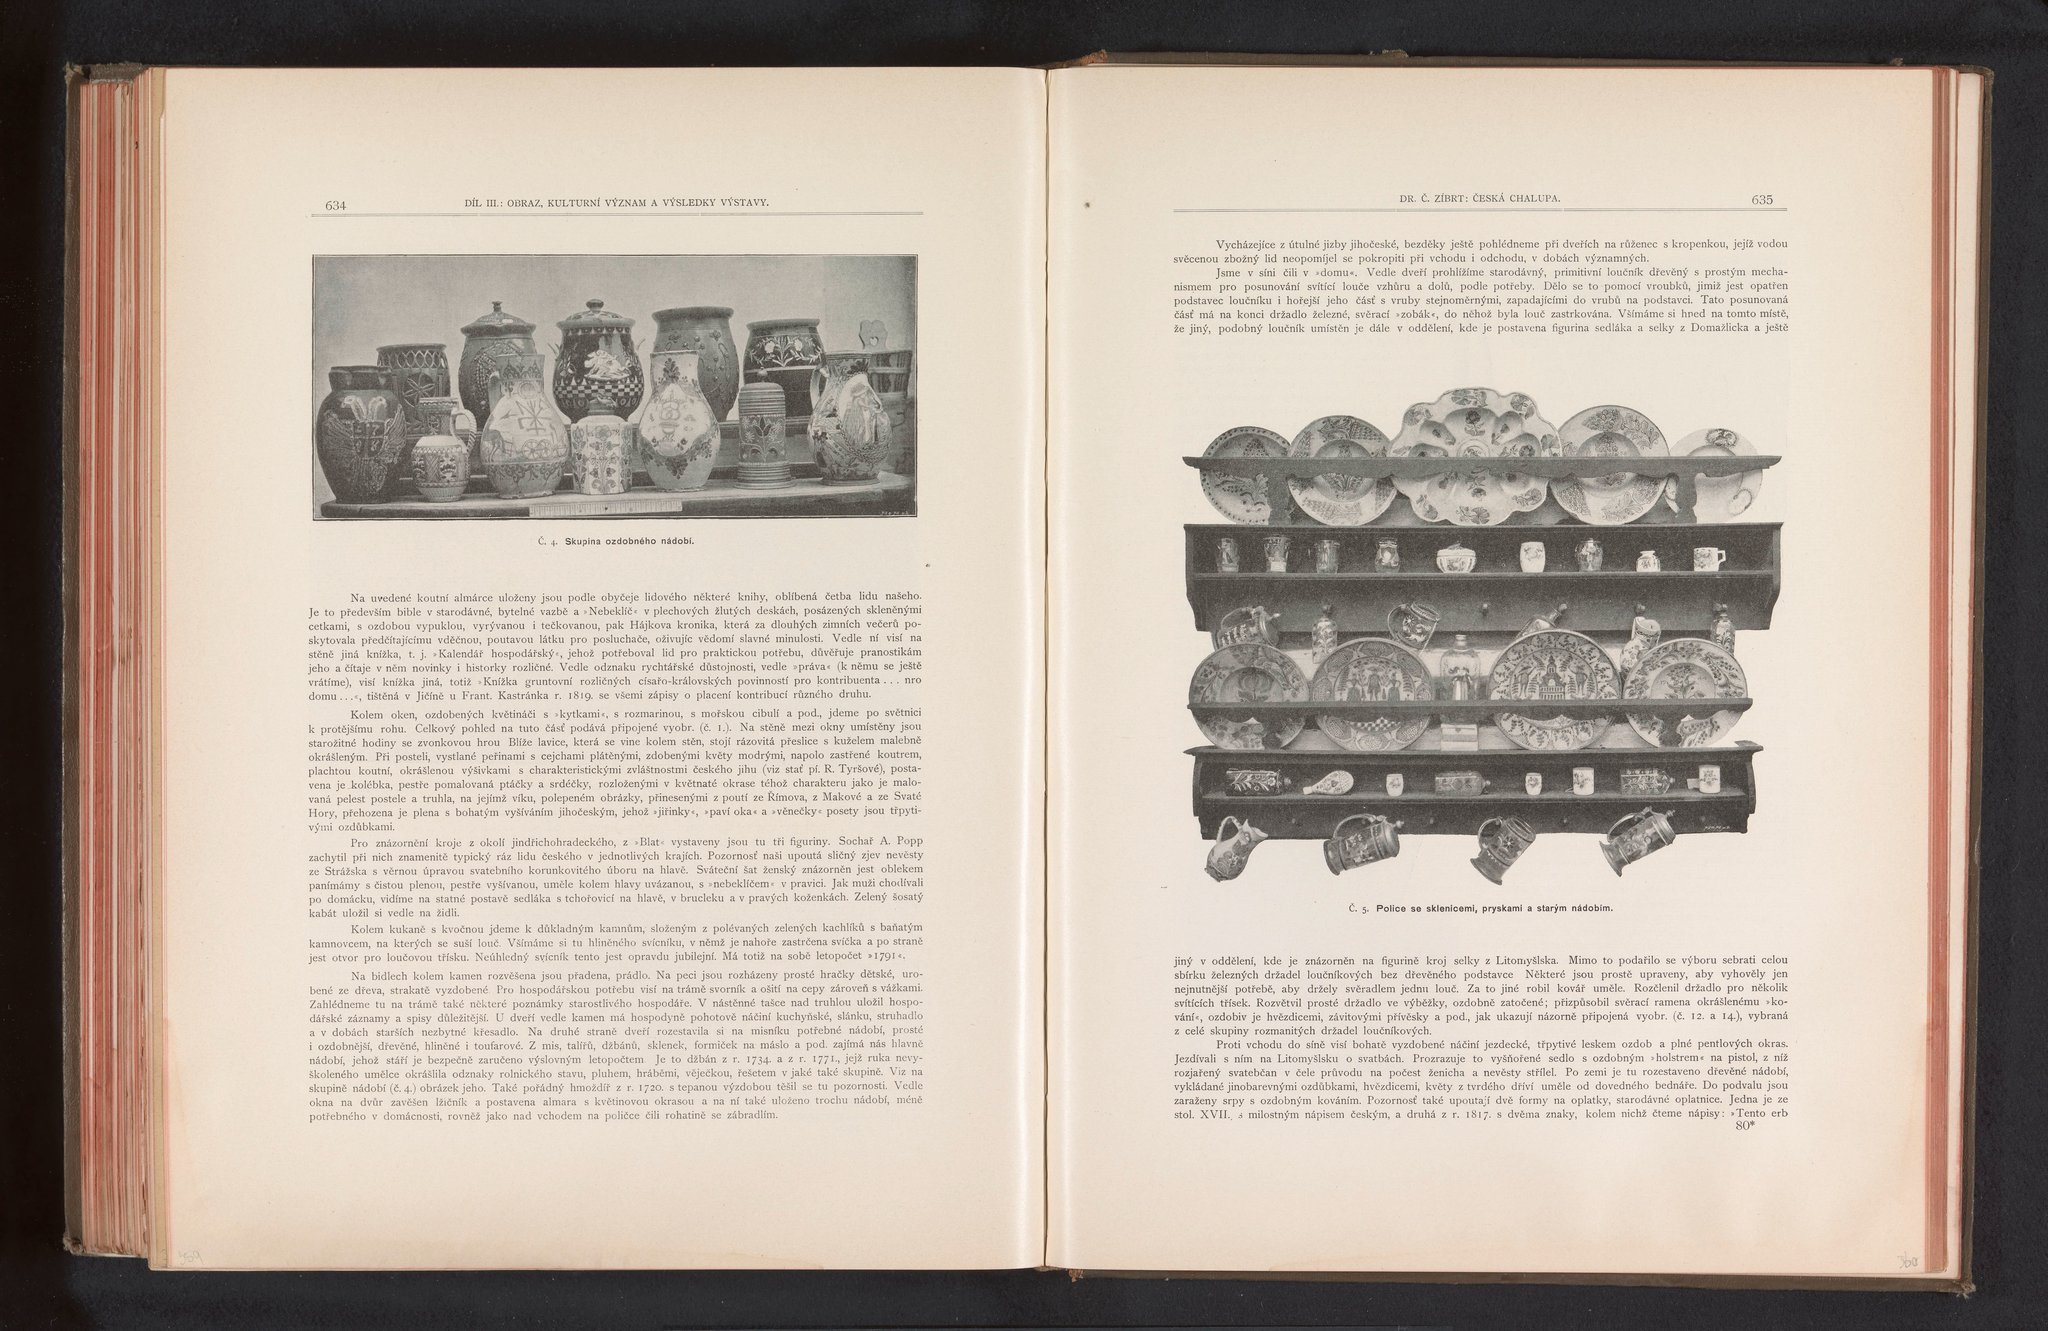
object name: photomechanical print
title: Police se sklenicemi, pryskami a starým nádobim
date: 1891-1895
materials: paper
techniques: autotype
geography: prague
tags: shelves, rack, sideboard, container of ceramics: jar, jug, pot, vase